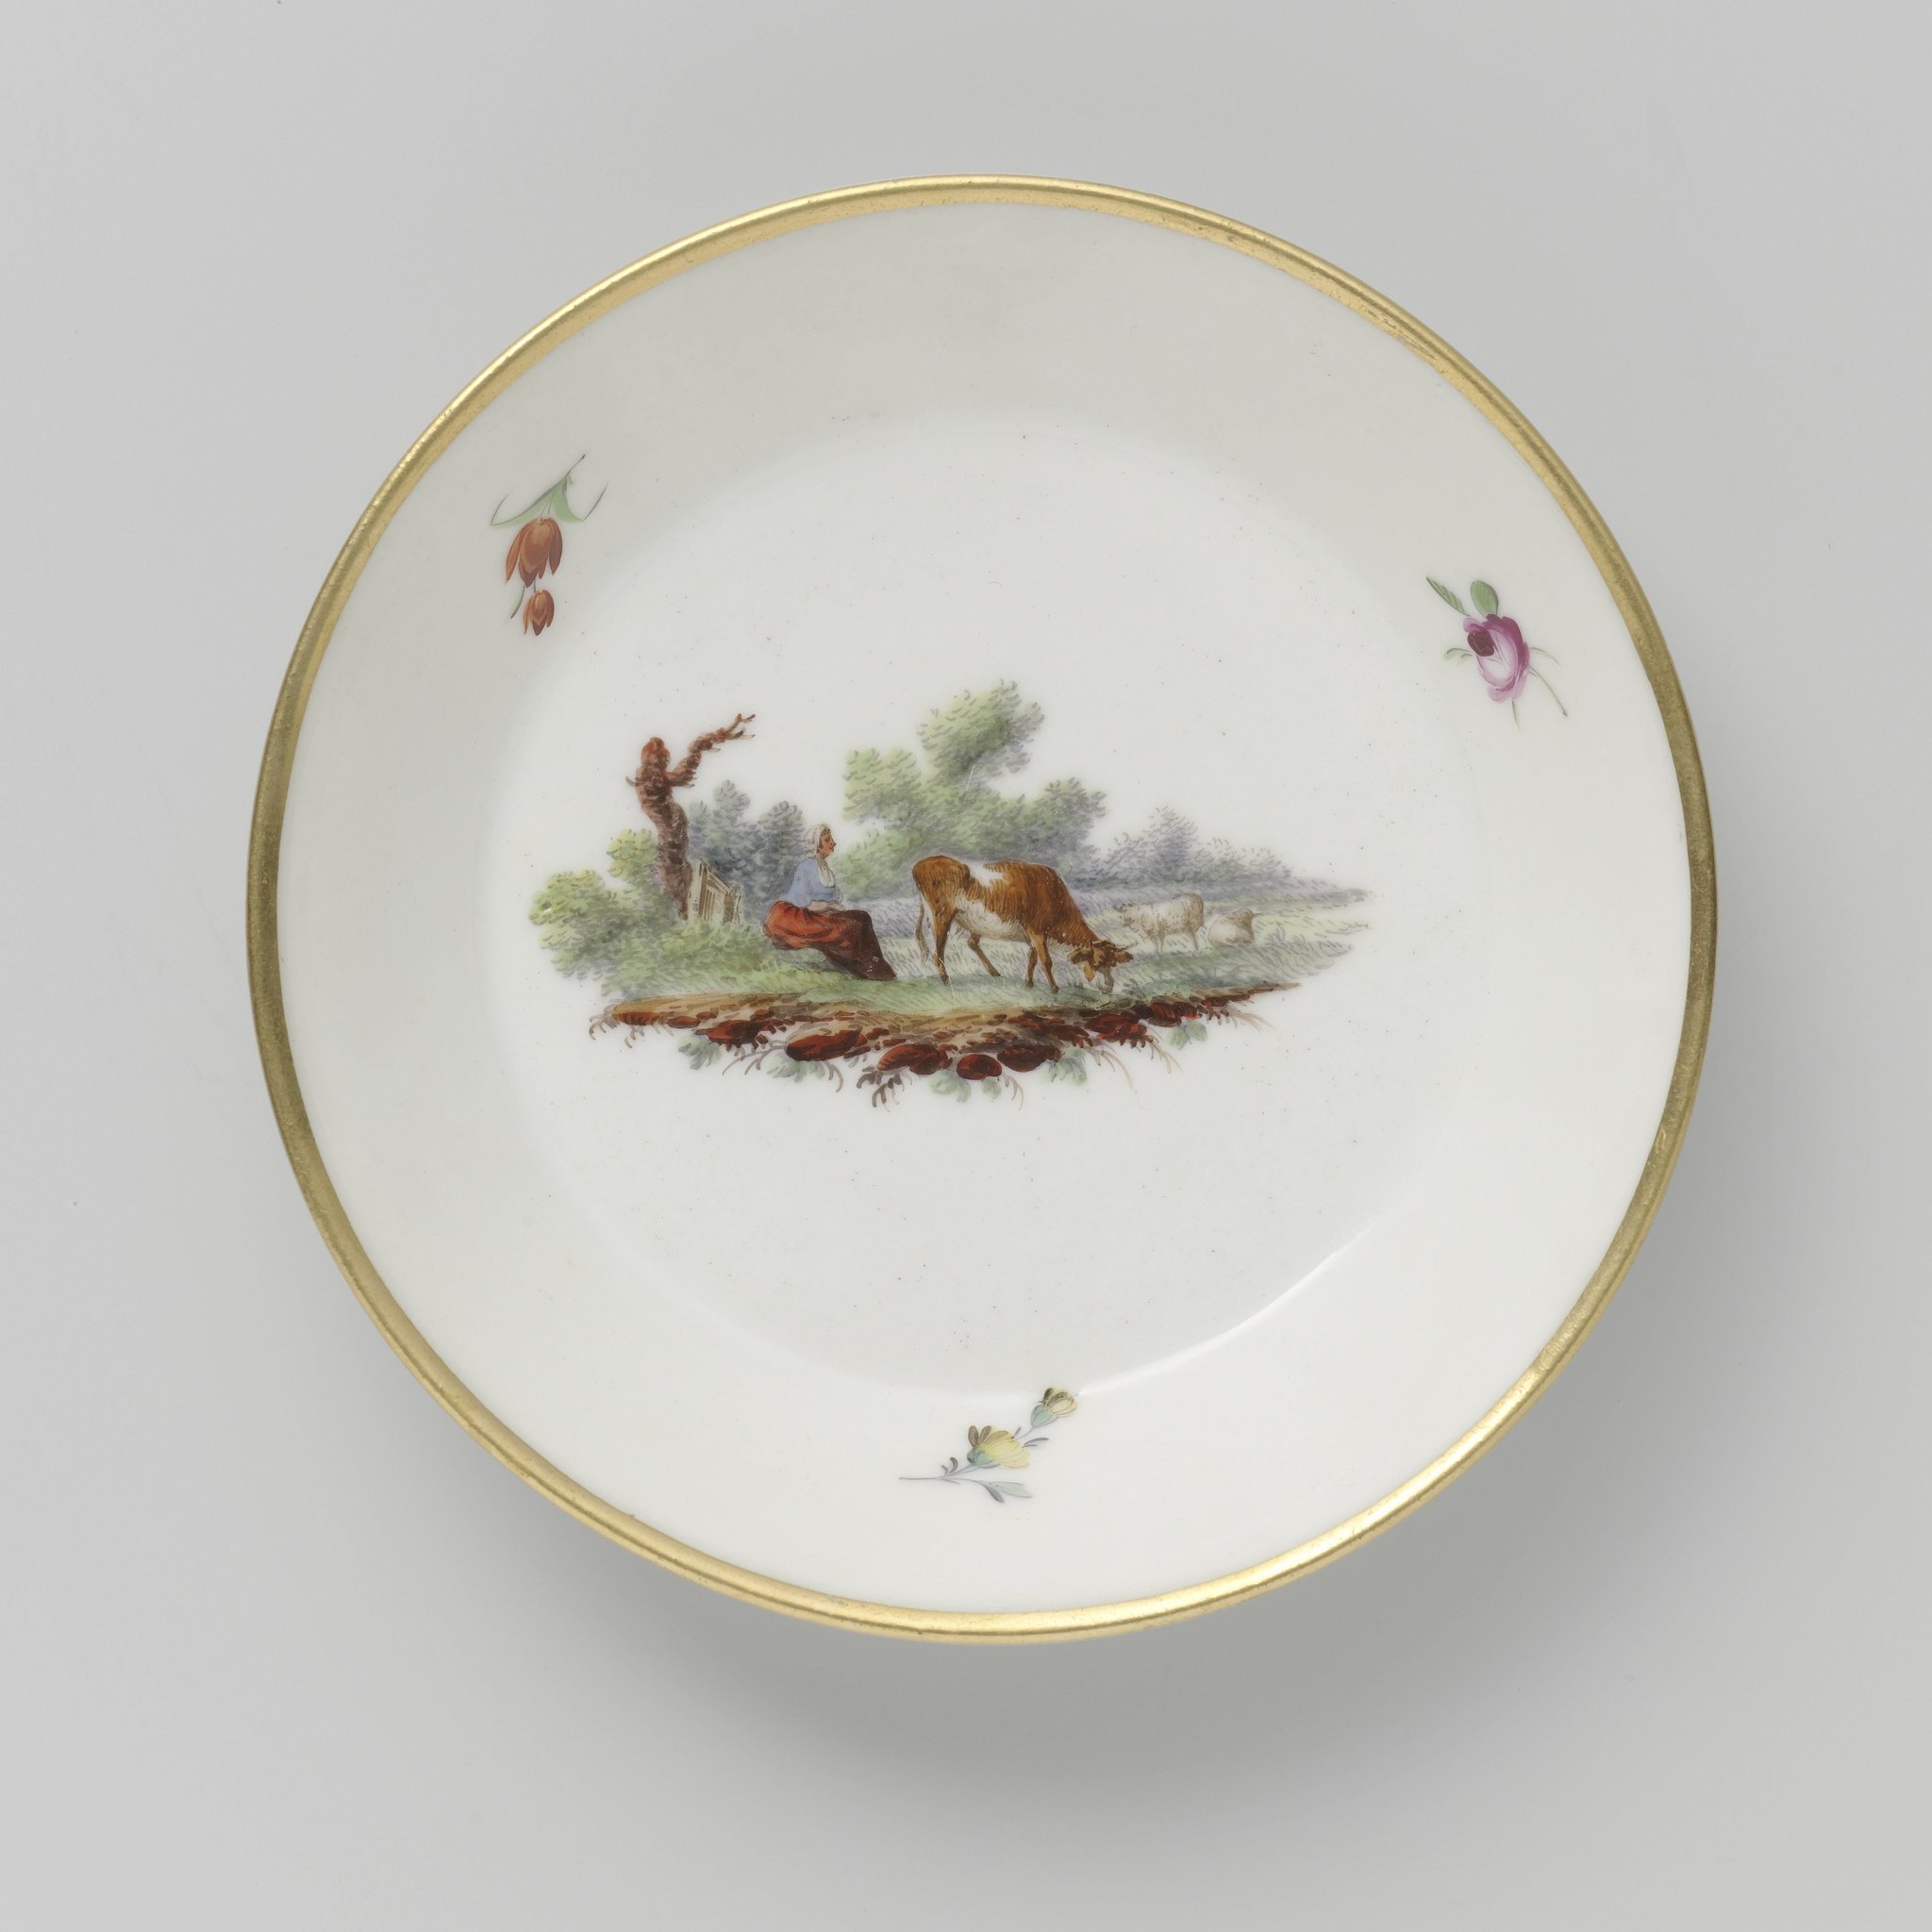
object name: platter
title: Schotel, beschilderd met een landschap met vee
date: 1809-1814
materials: porcelain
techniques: painted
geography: nieuwer-amstel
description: Schotel, beschilderd met landschap met vee. Gemerkt: Amstel in blauw.